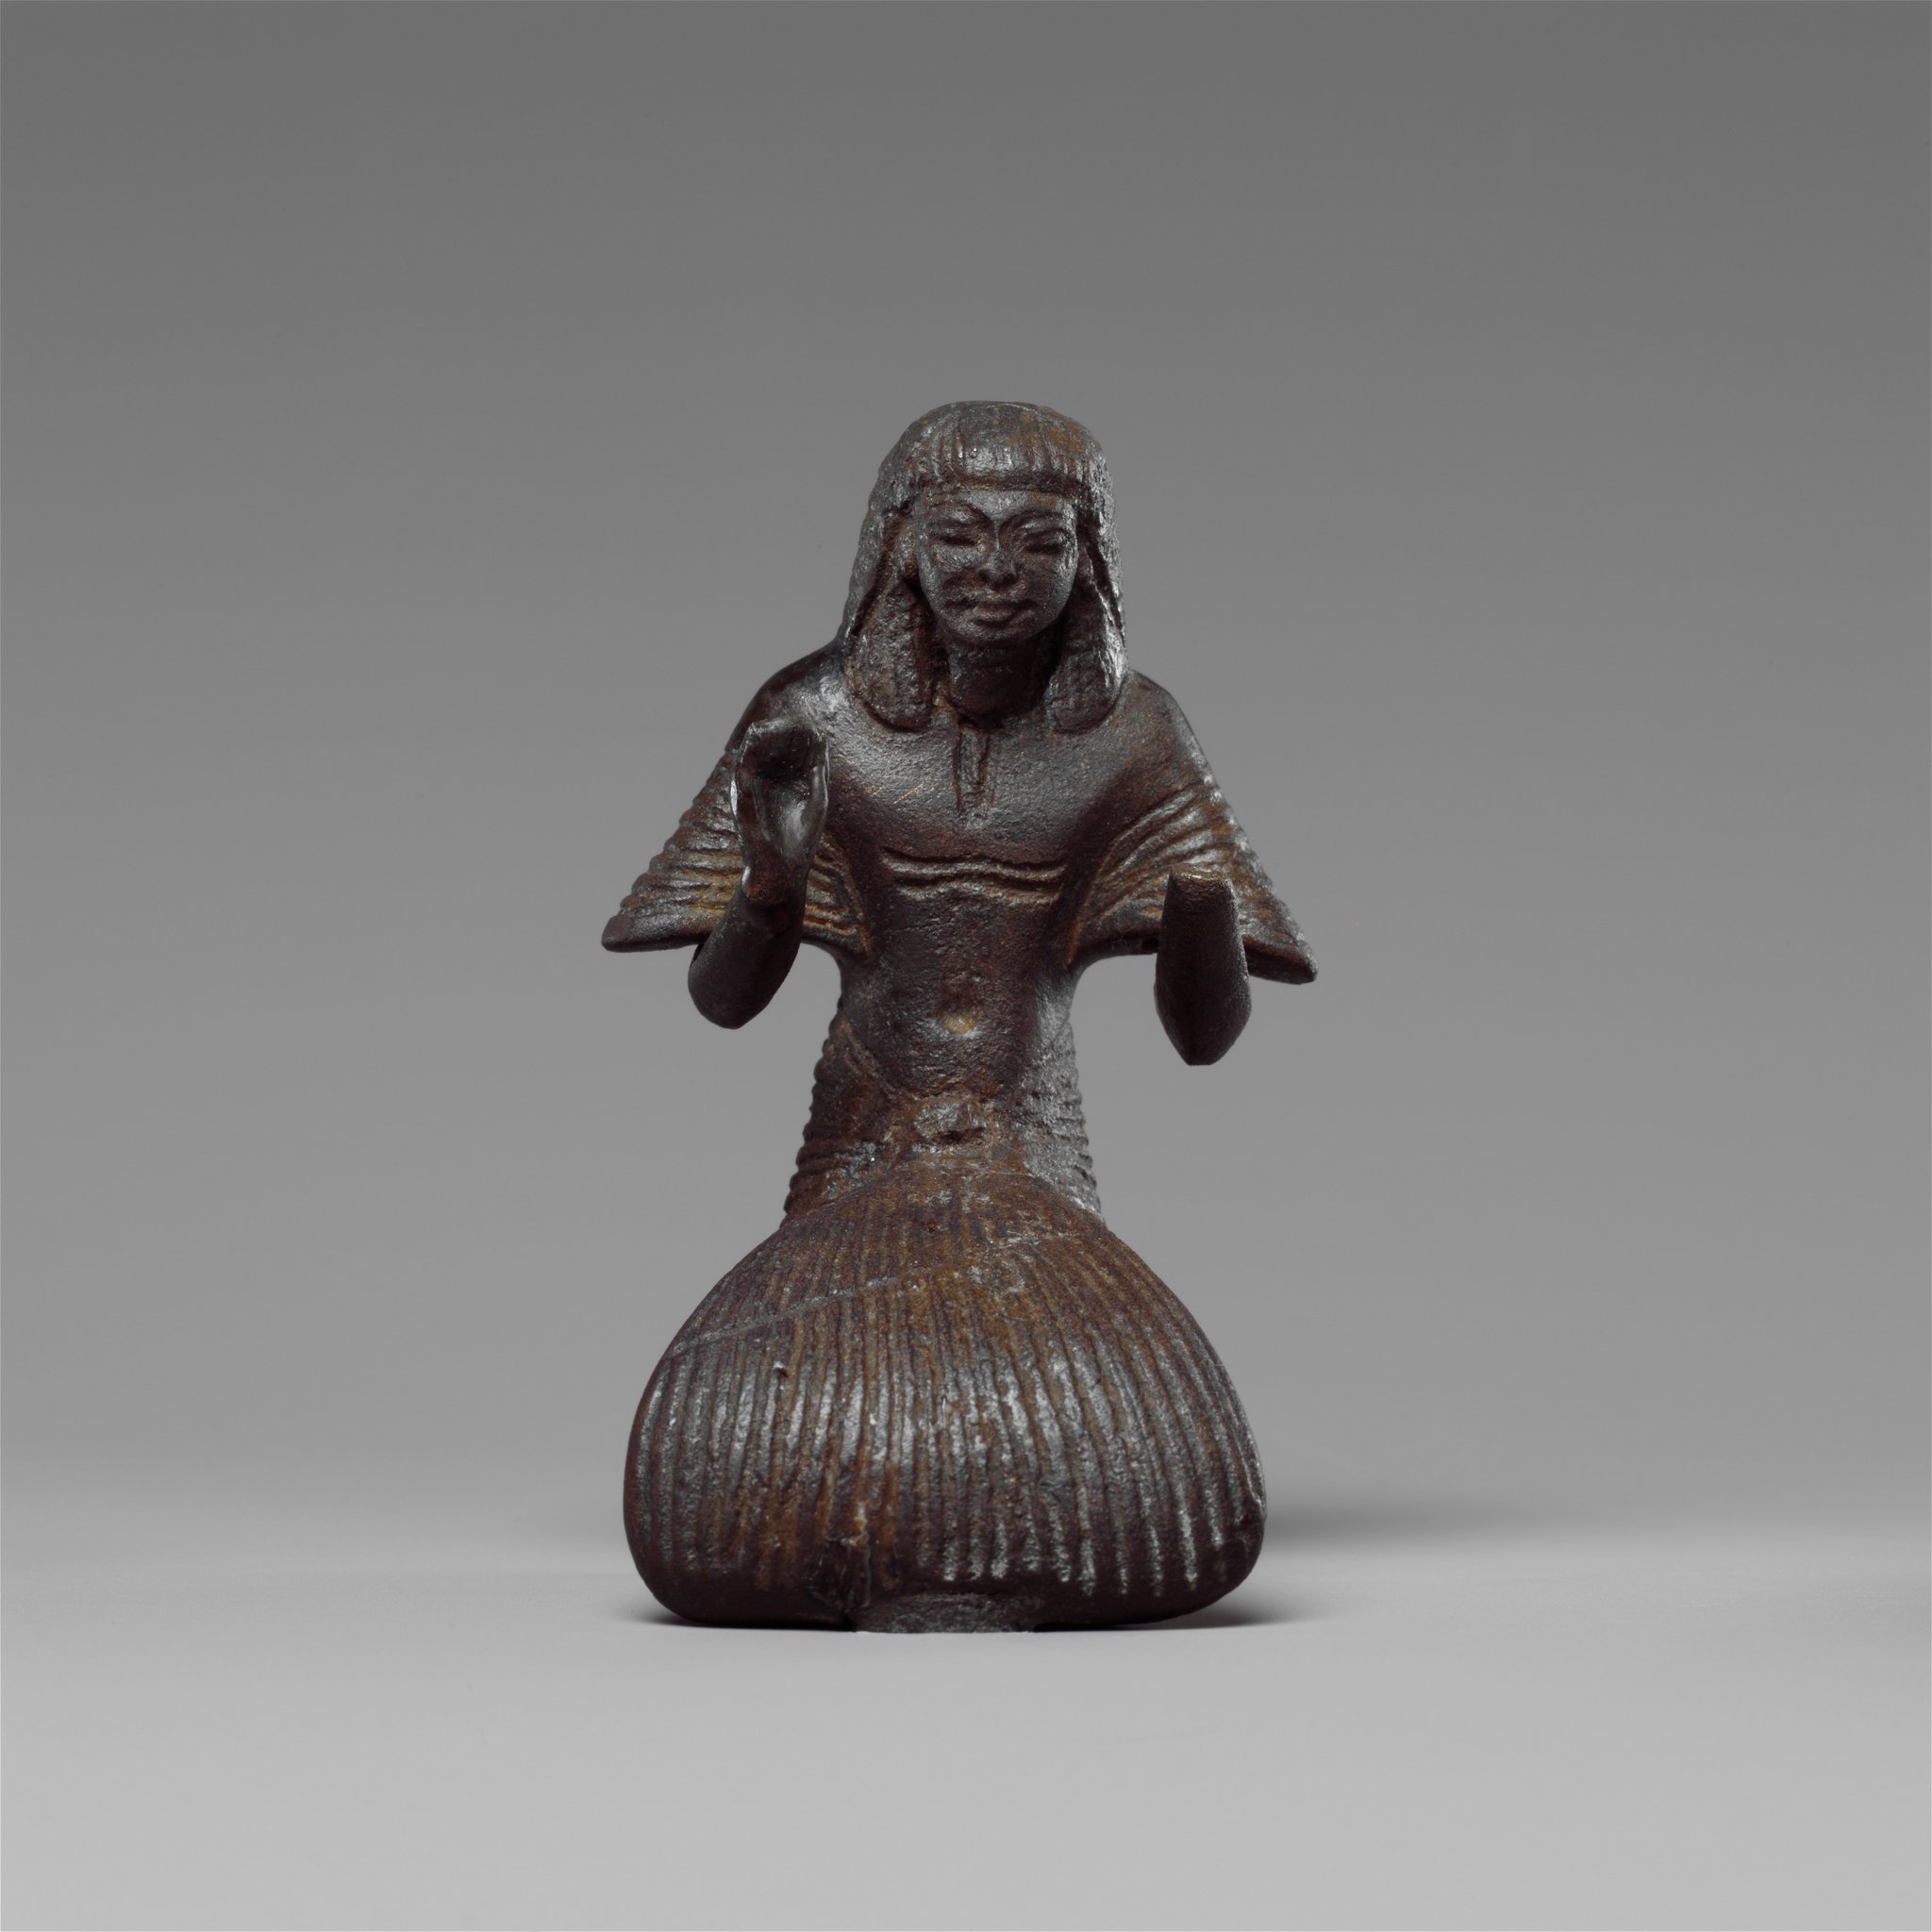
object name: statuette, kneeling official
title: Kneeling official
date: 1250-1070 BCE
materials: bronze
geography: egypt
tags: men